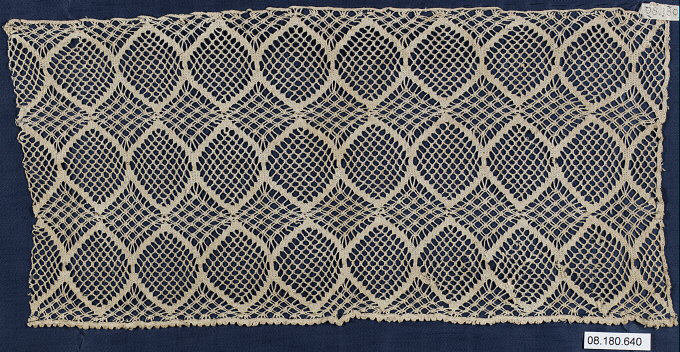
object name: piece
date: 1801-1900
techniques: crochet